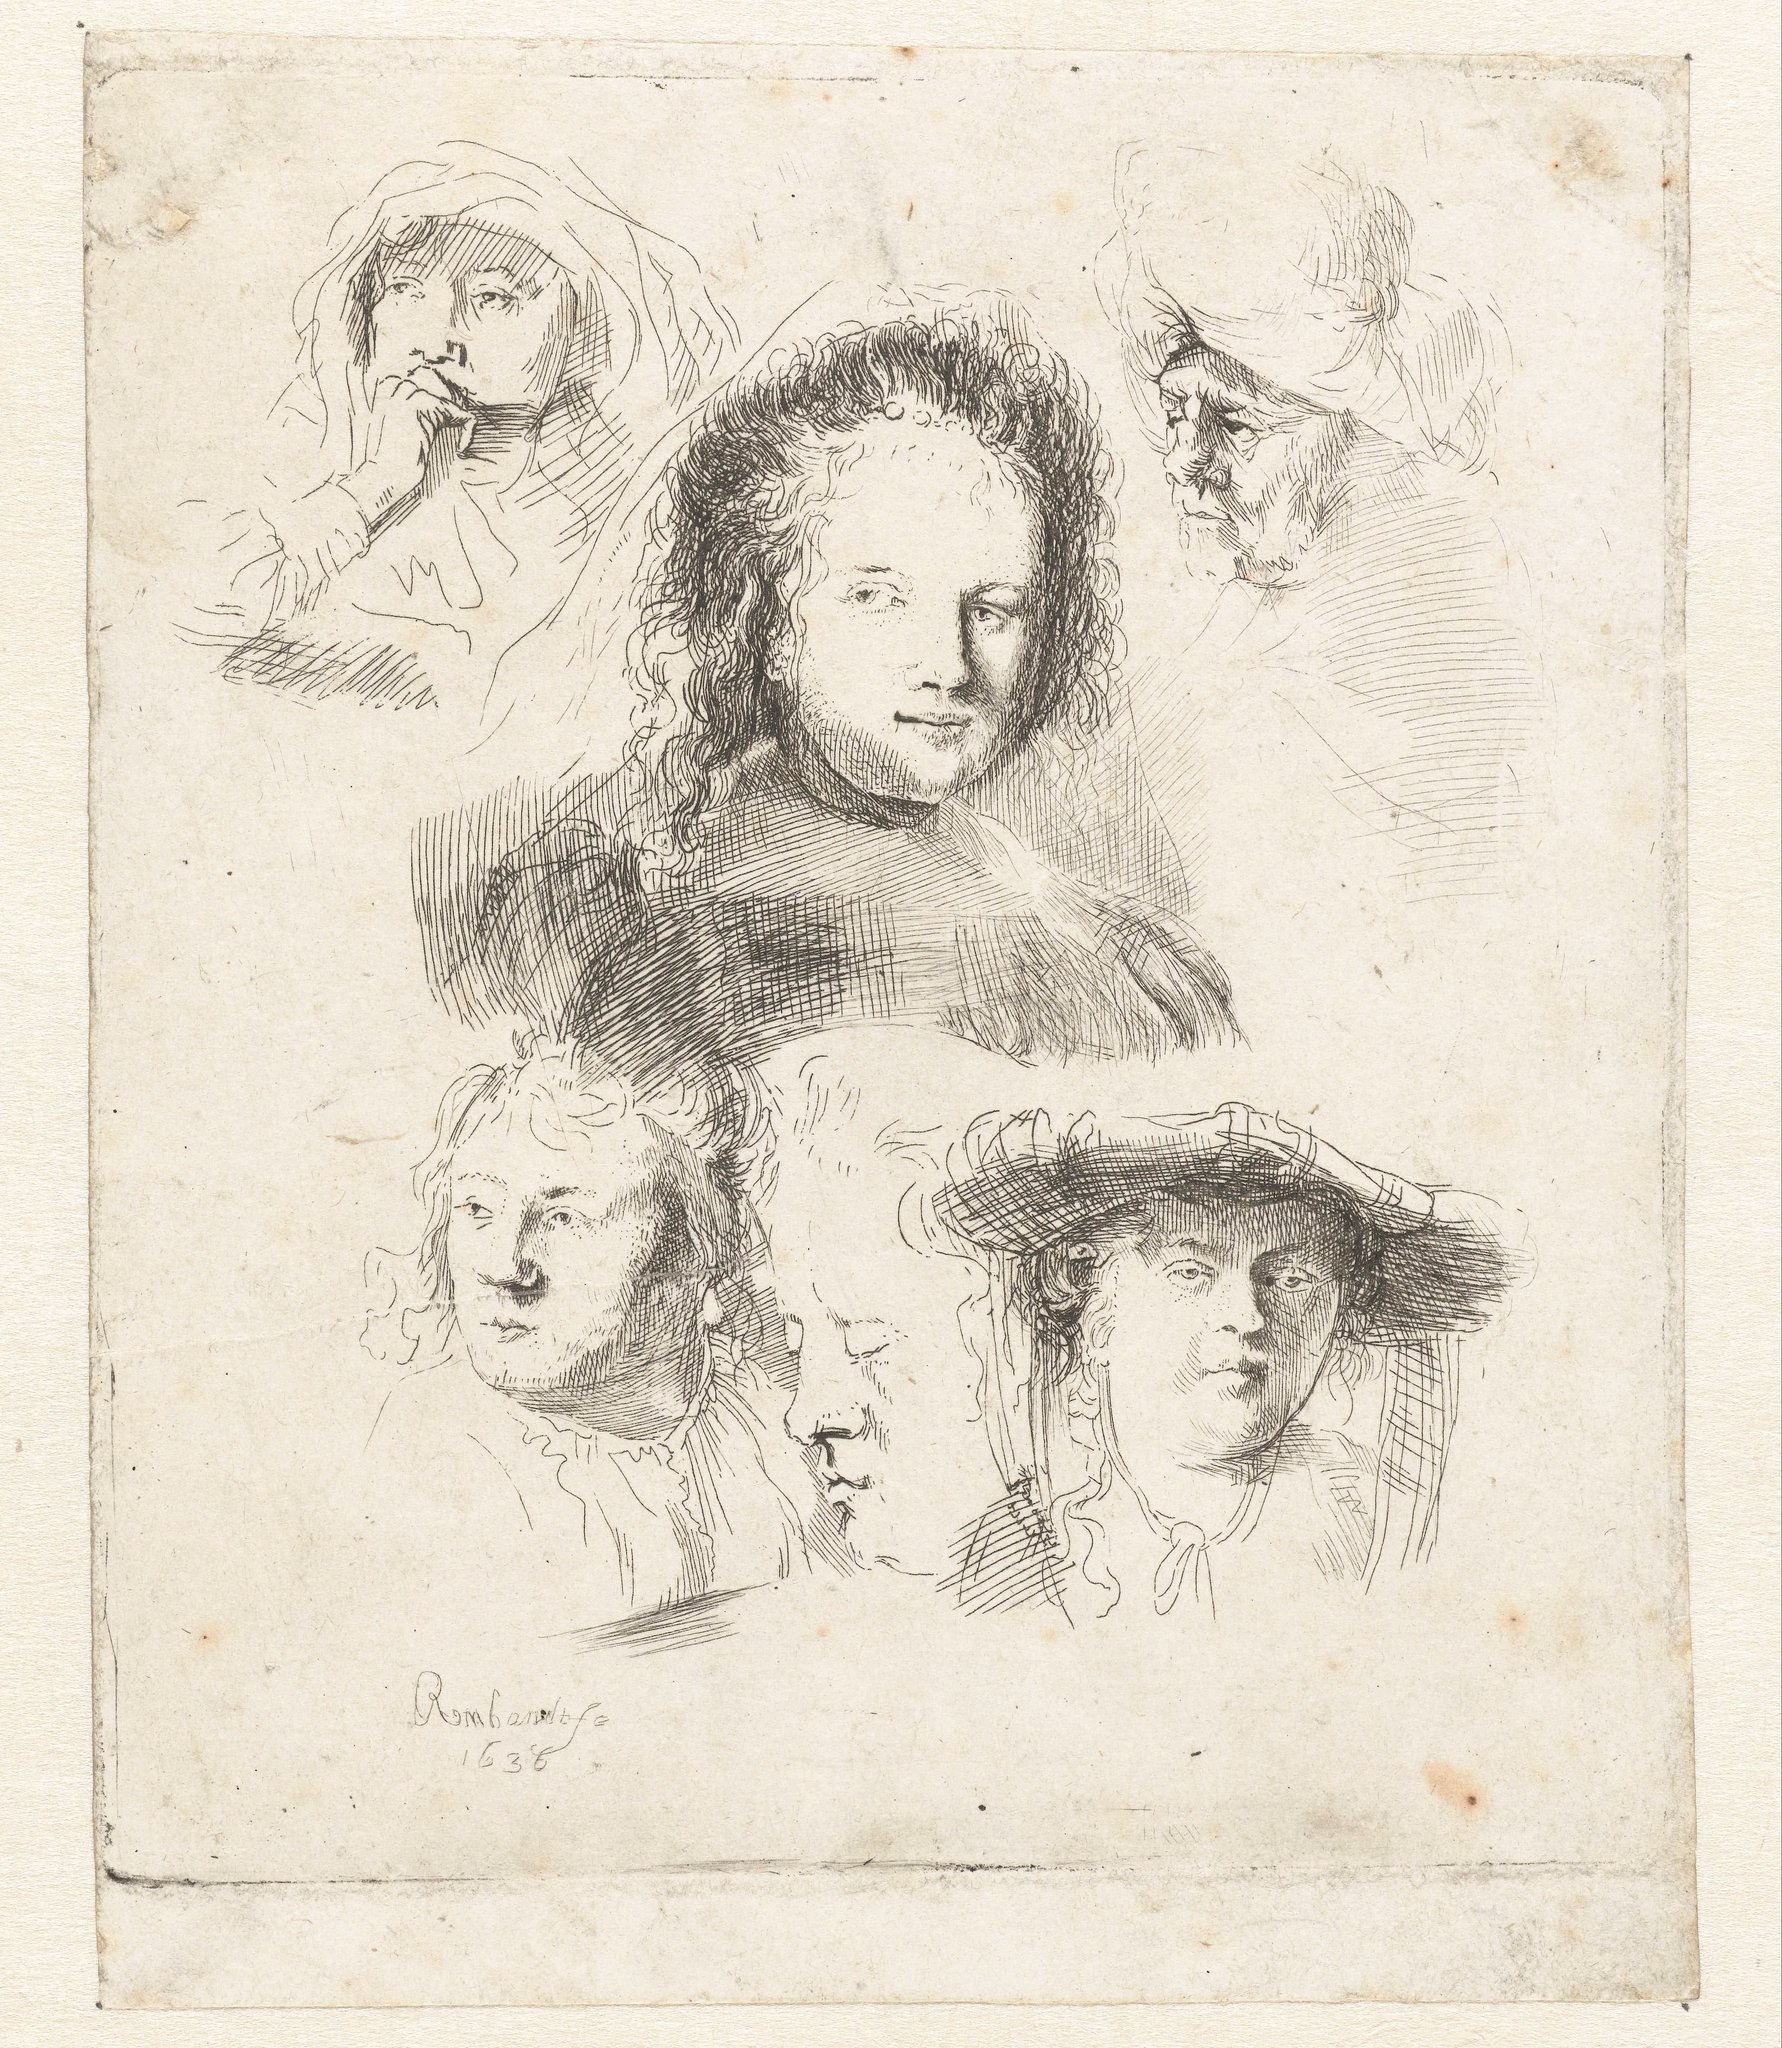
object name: print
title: Studies of the head of Saskia and others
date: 1636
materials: paper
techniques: etching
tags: amsterdam, drawing, sketch, historical persons - bb - woman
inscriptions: collector's mark: Lugt 2228, collector's mark: Lugt 2760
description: Spiegelbeeldige kopie naar de gelijknamige prent van Rembrandt.